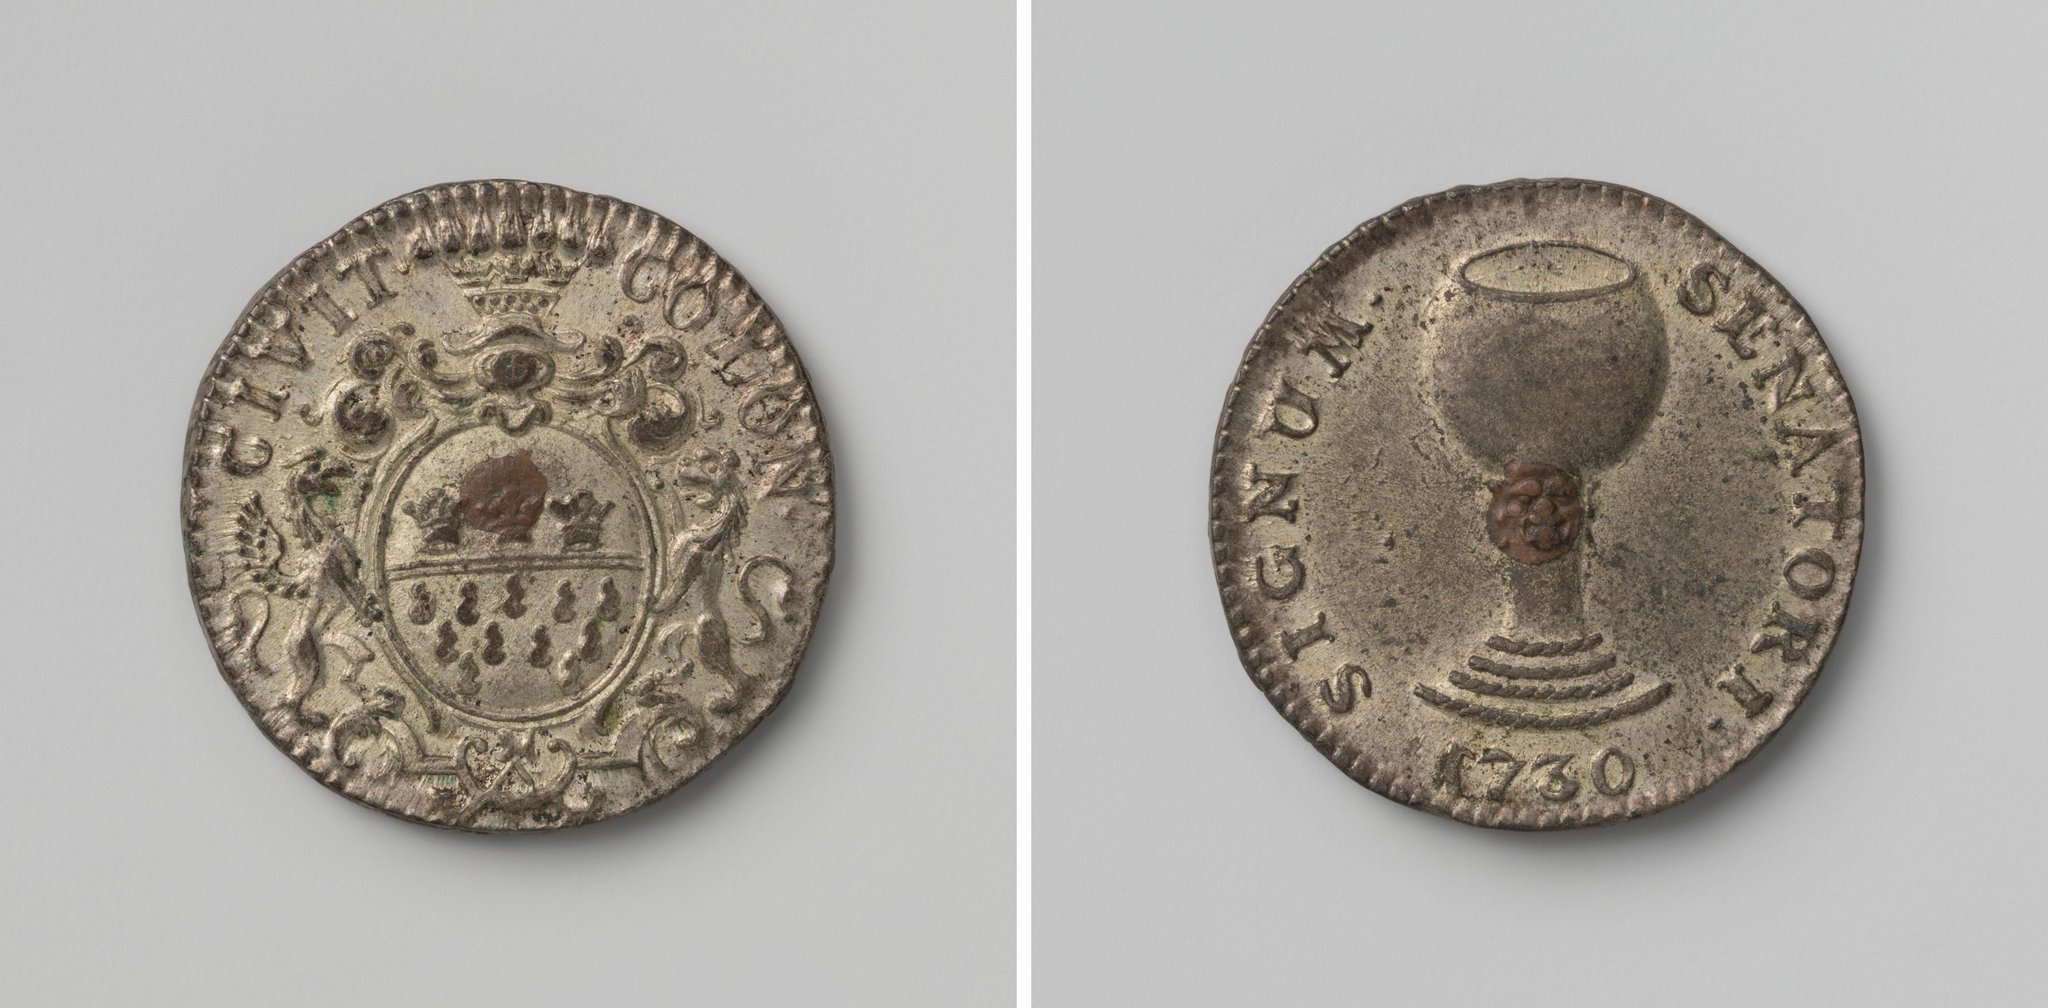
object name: council medal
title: Vroedschapspenning van de stad Keulen, penning uitgereikt aan de leden van de stadsraad recht gevend op een kan bier of wijn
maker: Anonymous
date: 1730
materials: metal alloy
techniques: striking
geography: cologne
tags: cologne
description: Penning. Voorzijde: gehelmd wapenschild, geflankeerd door griffioen en leeuw binnen omschrift. Keerzijde: kelk met op voet een gezichtje binnen omschrift; randschrift